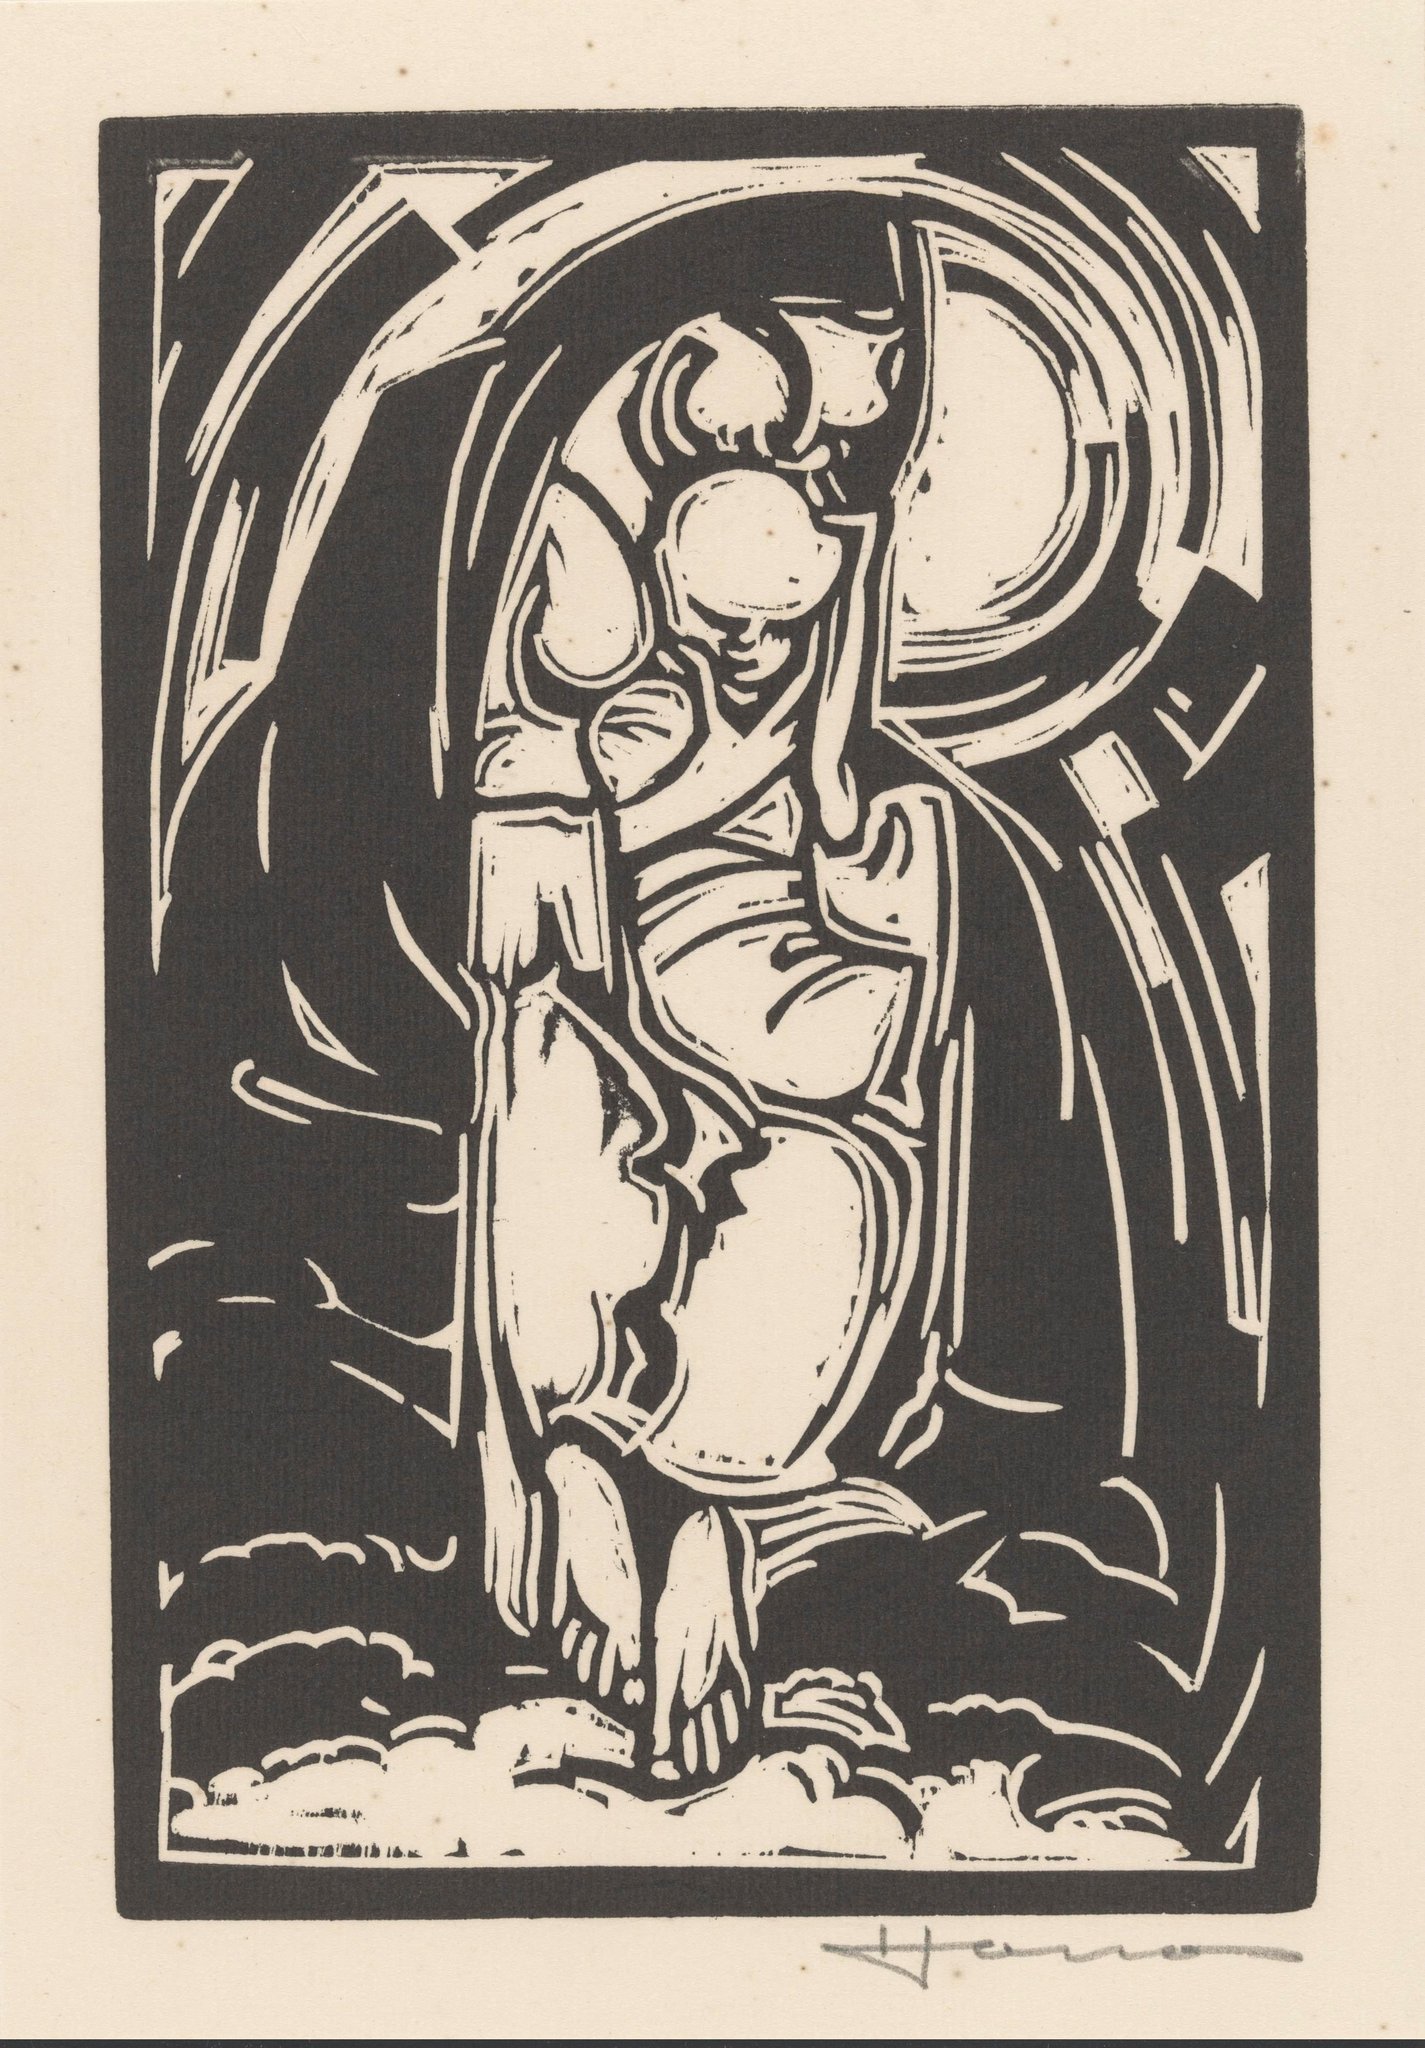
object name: print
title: Figuur die zijn kin vasthoudt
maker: henri jonas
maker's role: draughtsman, print maker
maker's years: 1878-1944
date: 1888-1931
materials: paper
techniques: woodcut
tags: hand(s) bent towards the head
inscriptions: collector's mark: Lugt 2228